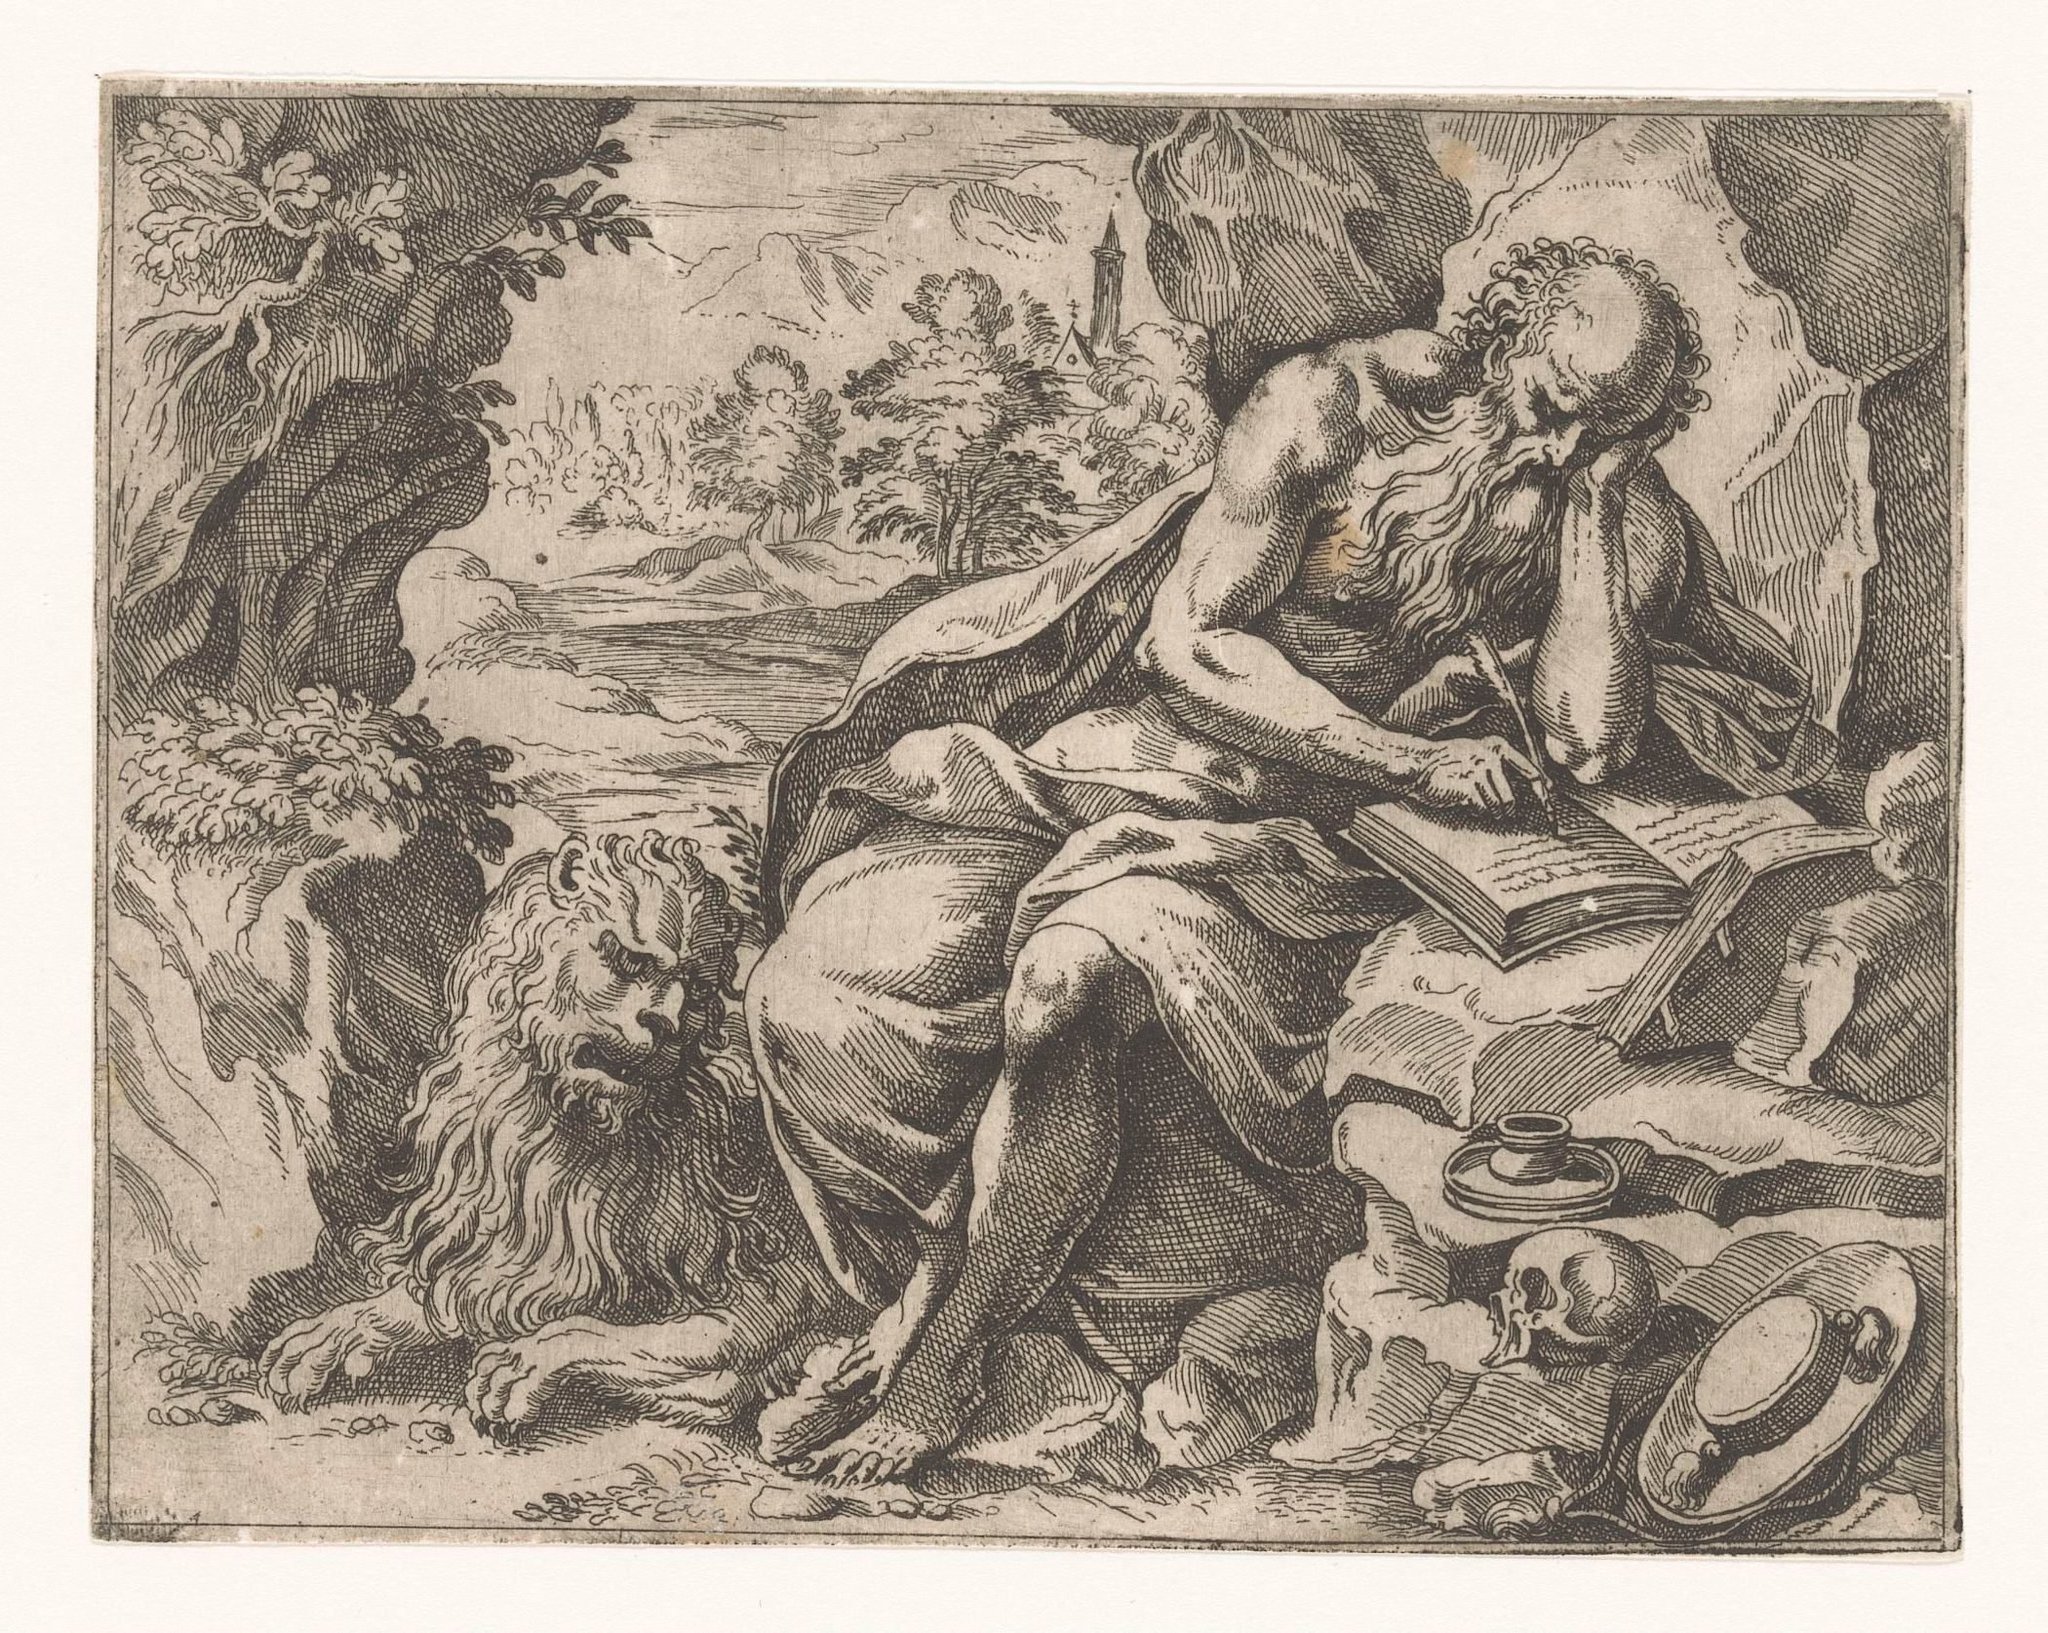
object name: print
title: Heilige Hieronymus in de wildernis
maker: vespasiano strada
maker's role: draughtsman, painter, print maker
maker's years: 1582-1622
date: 1592-1622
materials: paper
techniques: etching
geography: italy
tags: st. jerome as penitent in the desert, half naked, kneeling before a crucifix and holding a stone in his hand to beat his breast; a skull (and other 'vanitas' symbols), sometimes a scorpion and a snake beside him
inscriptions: inscription: ‘6,1. - 21.’, collector's mark: Lugt 2228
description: In een grot zit de heilige Hieronymus te schrijven in een boek. Naast hem de leeuw, een inktpot, een schedel en een kardinaalshoed.